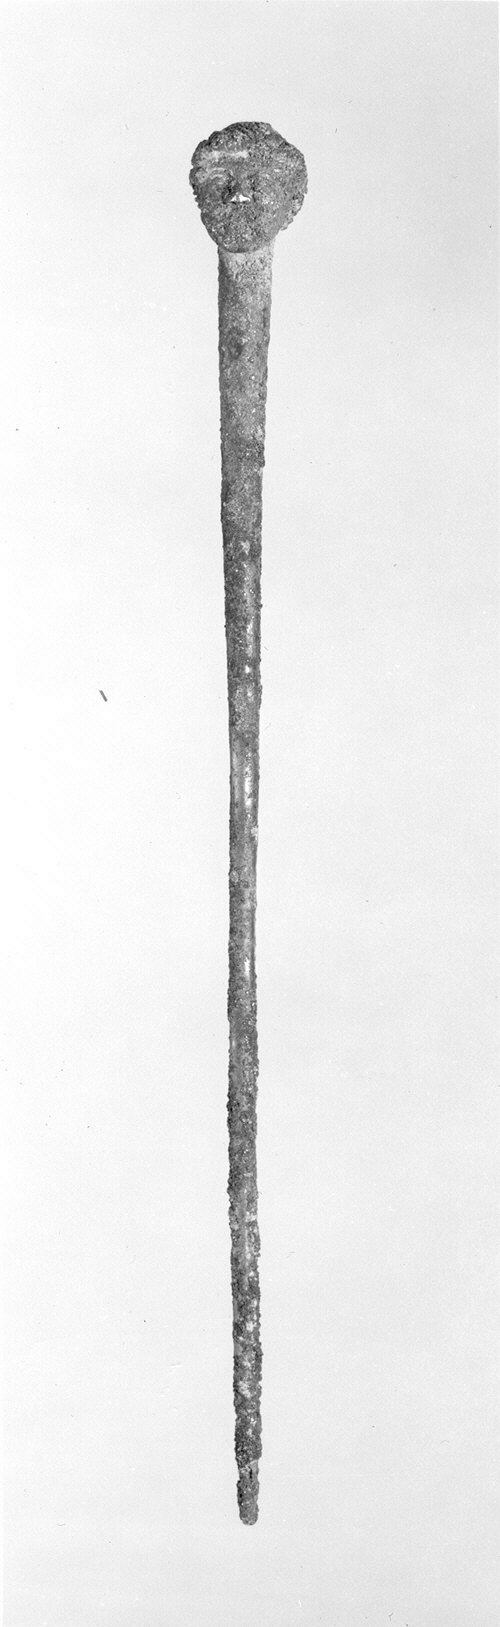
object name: pin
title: Pin terminating in a male head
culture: parthian or kushan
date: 1-100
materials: silver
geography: indus region or eastern iran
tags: heads